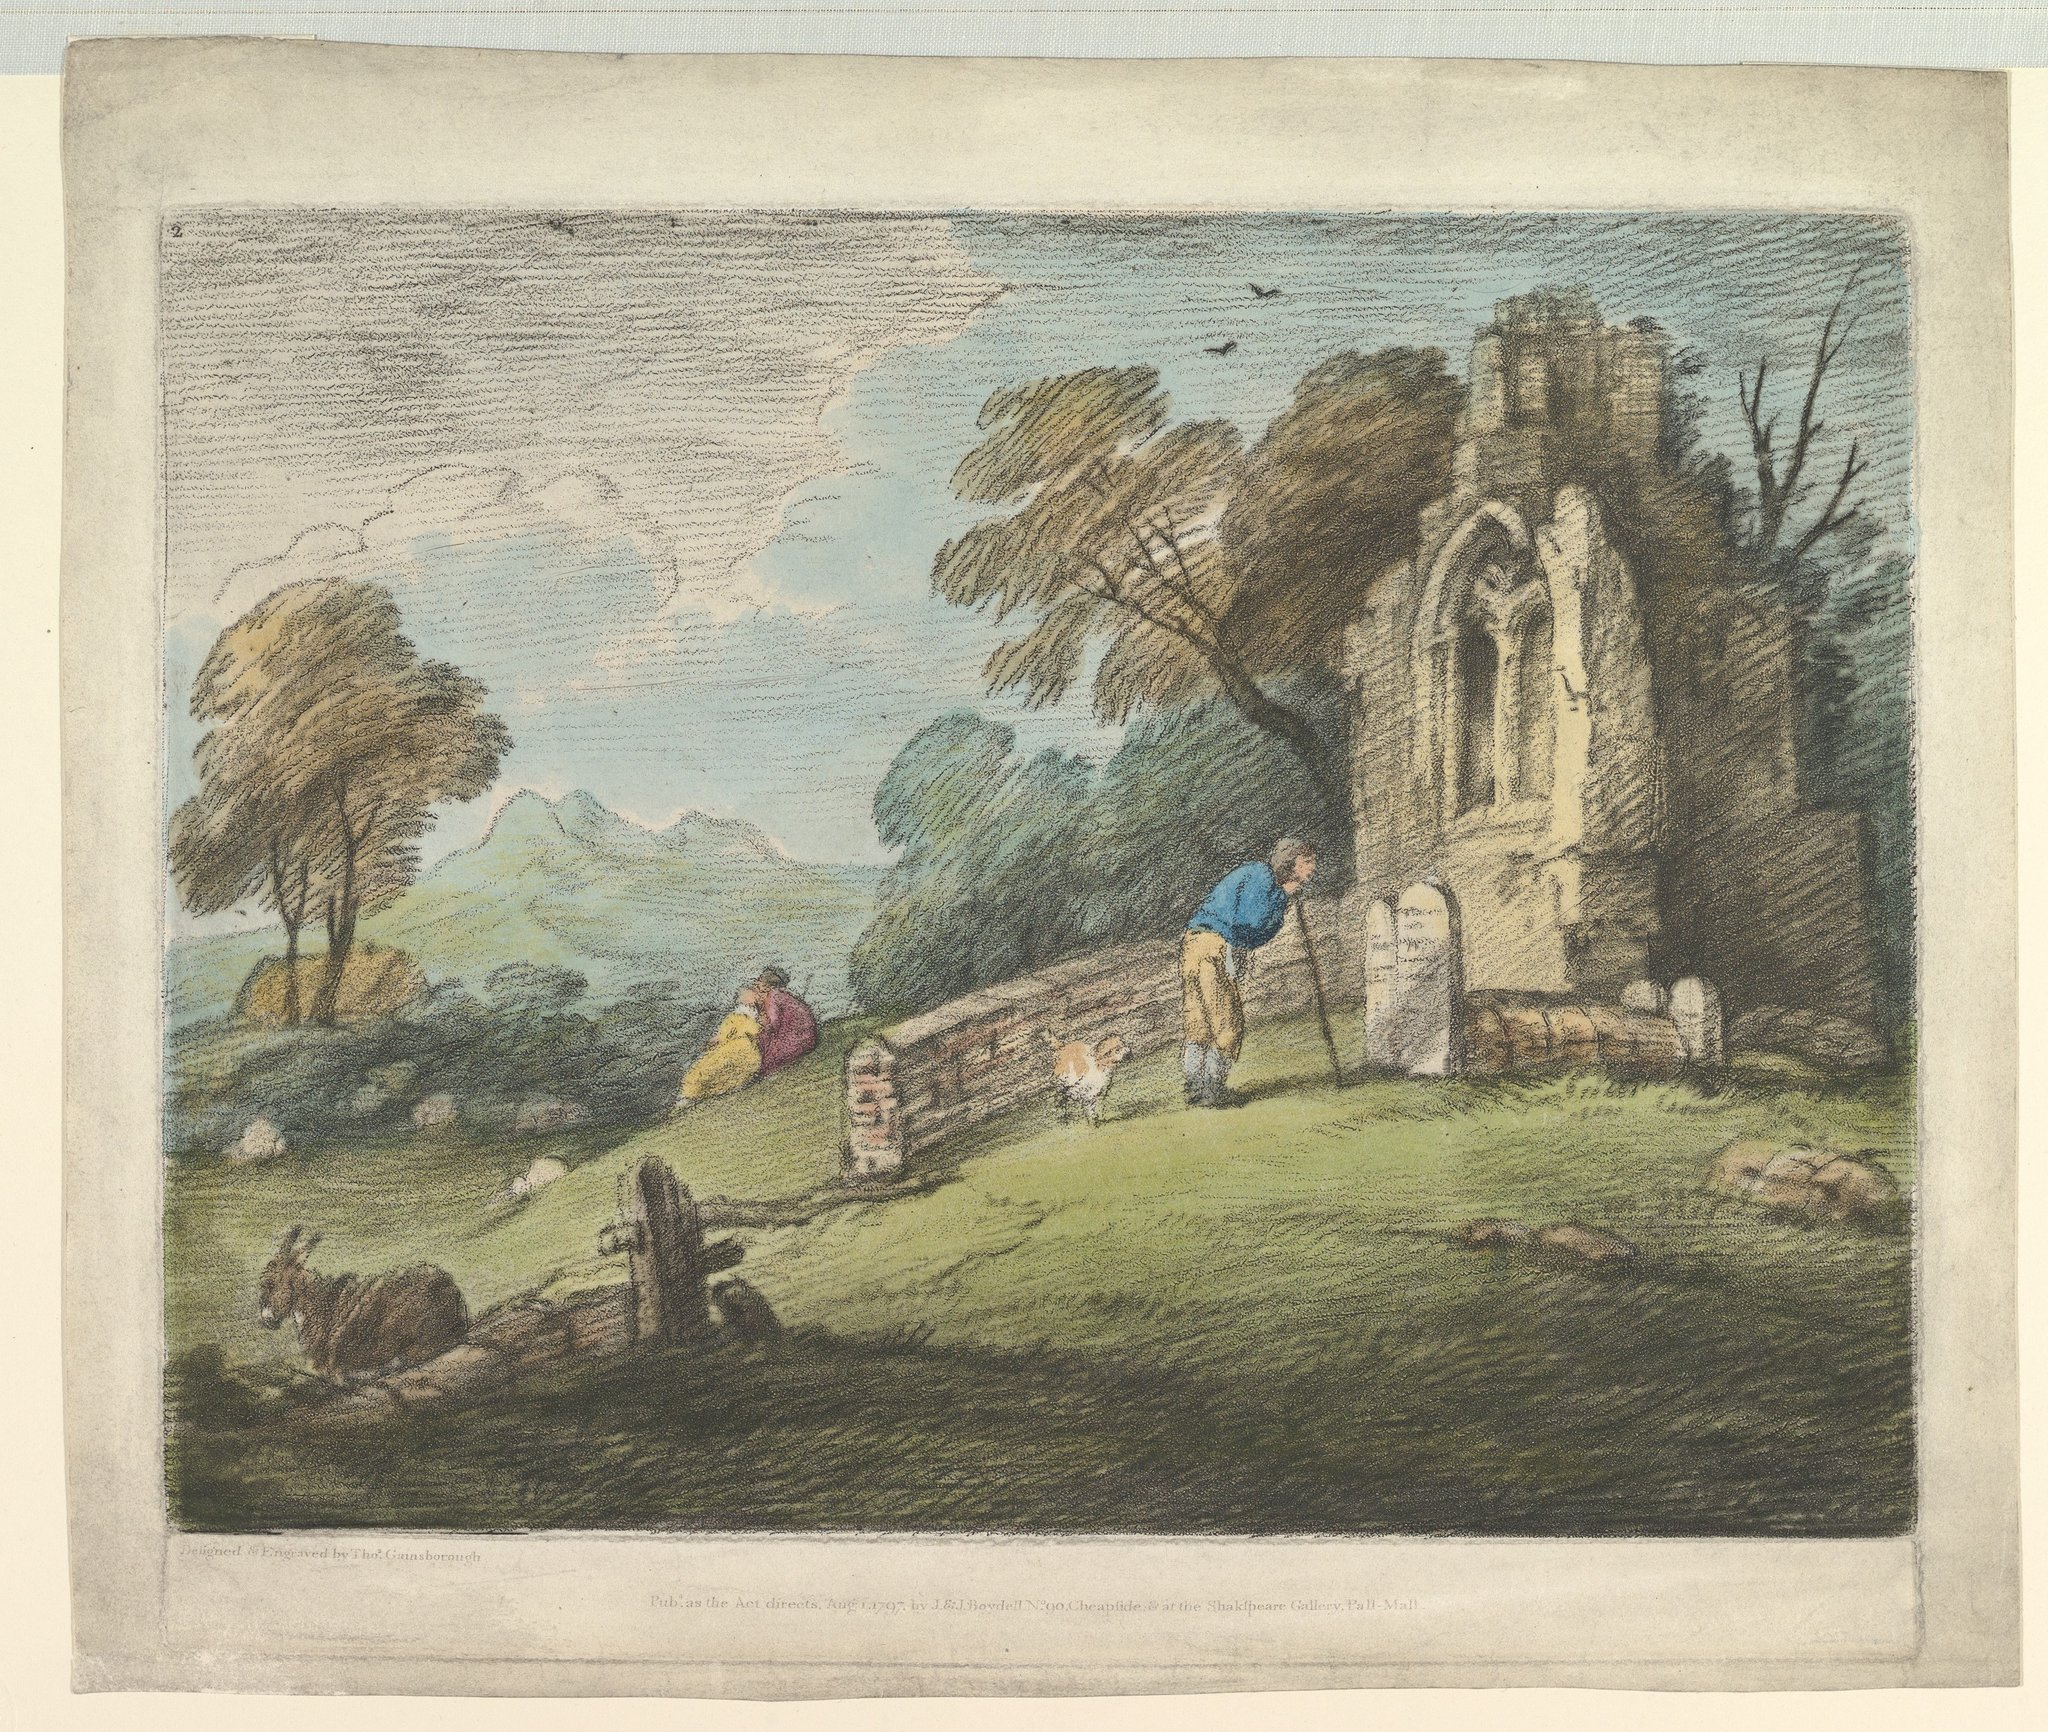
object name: print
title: Wooded Landscape with Peasant Reading Tombstone, Rustic Lovers and Ruined Church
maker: thomas gainsborough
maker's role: artist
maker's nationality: british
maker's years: 1727-1788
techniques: aquatint, hand coloring, etching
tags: churches,ruins,men,lovers,reading